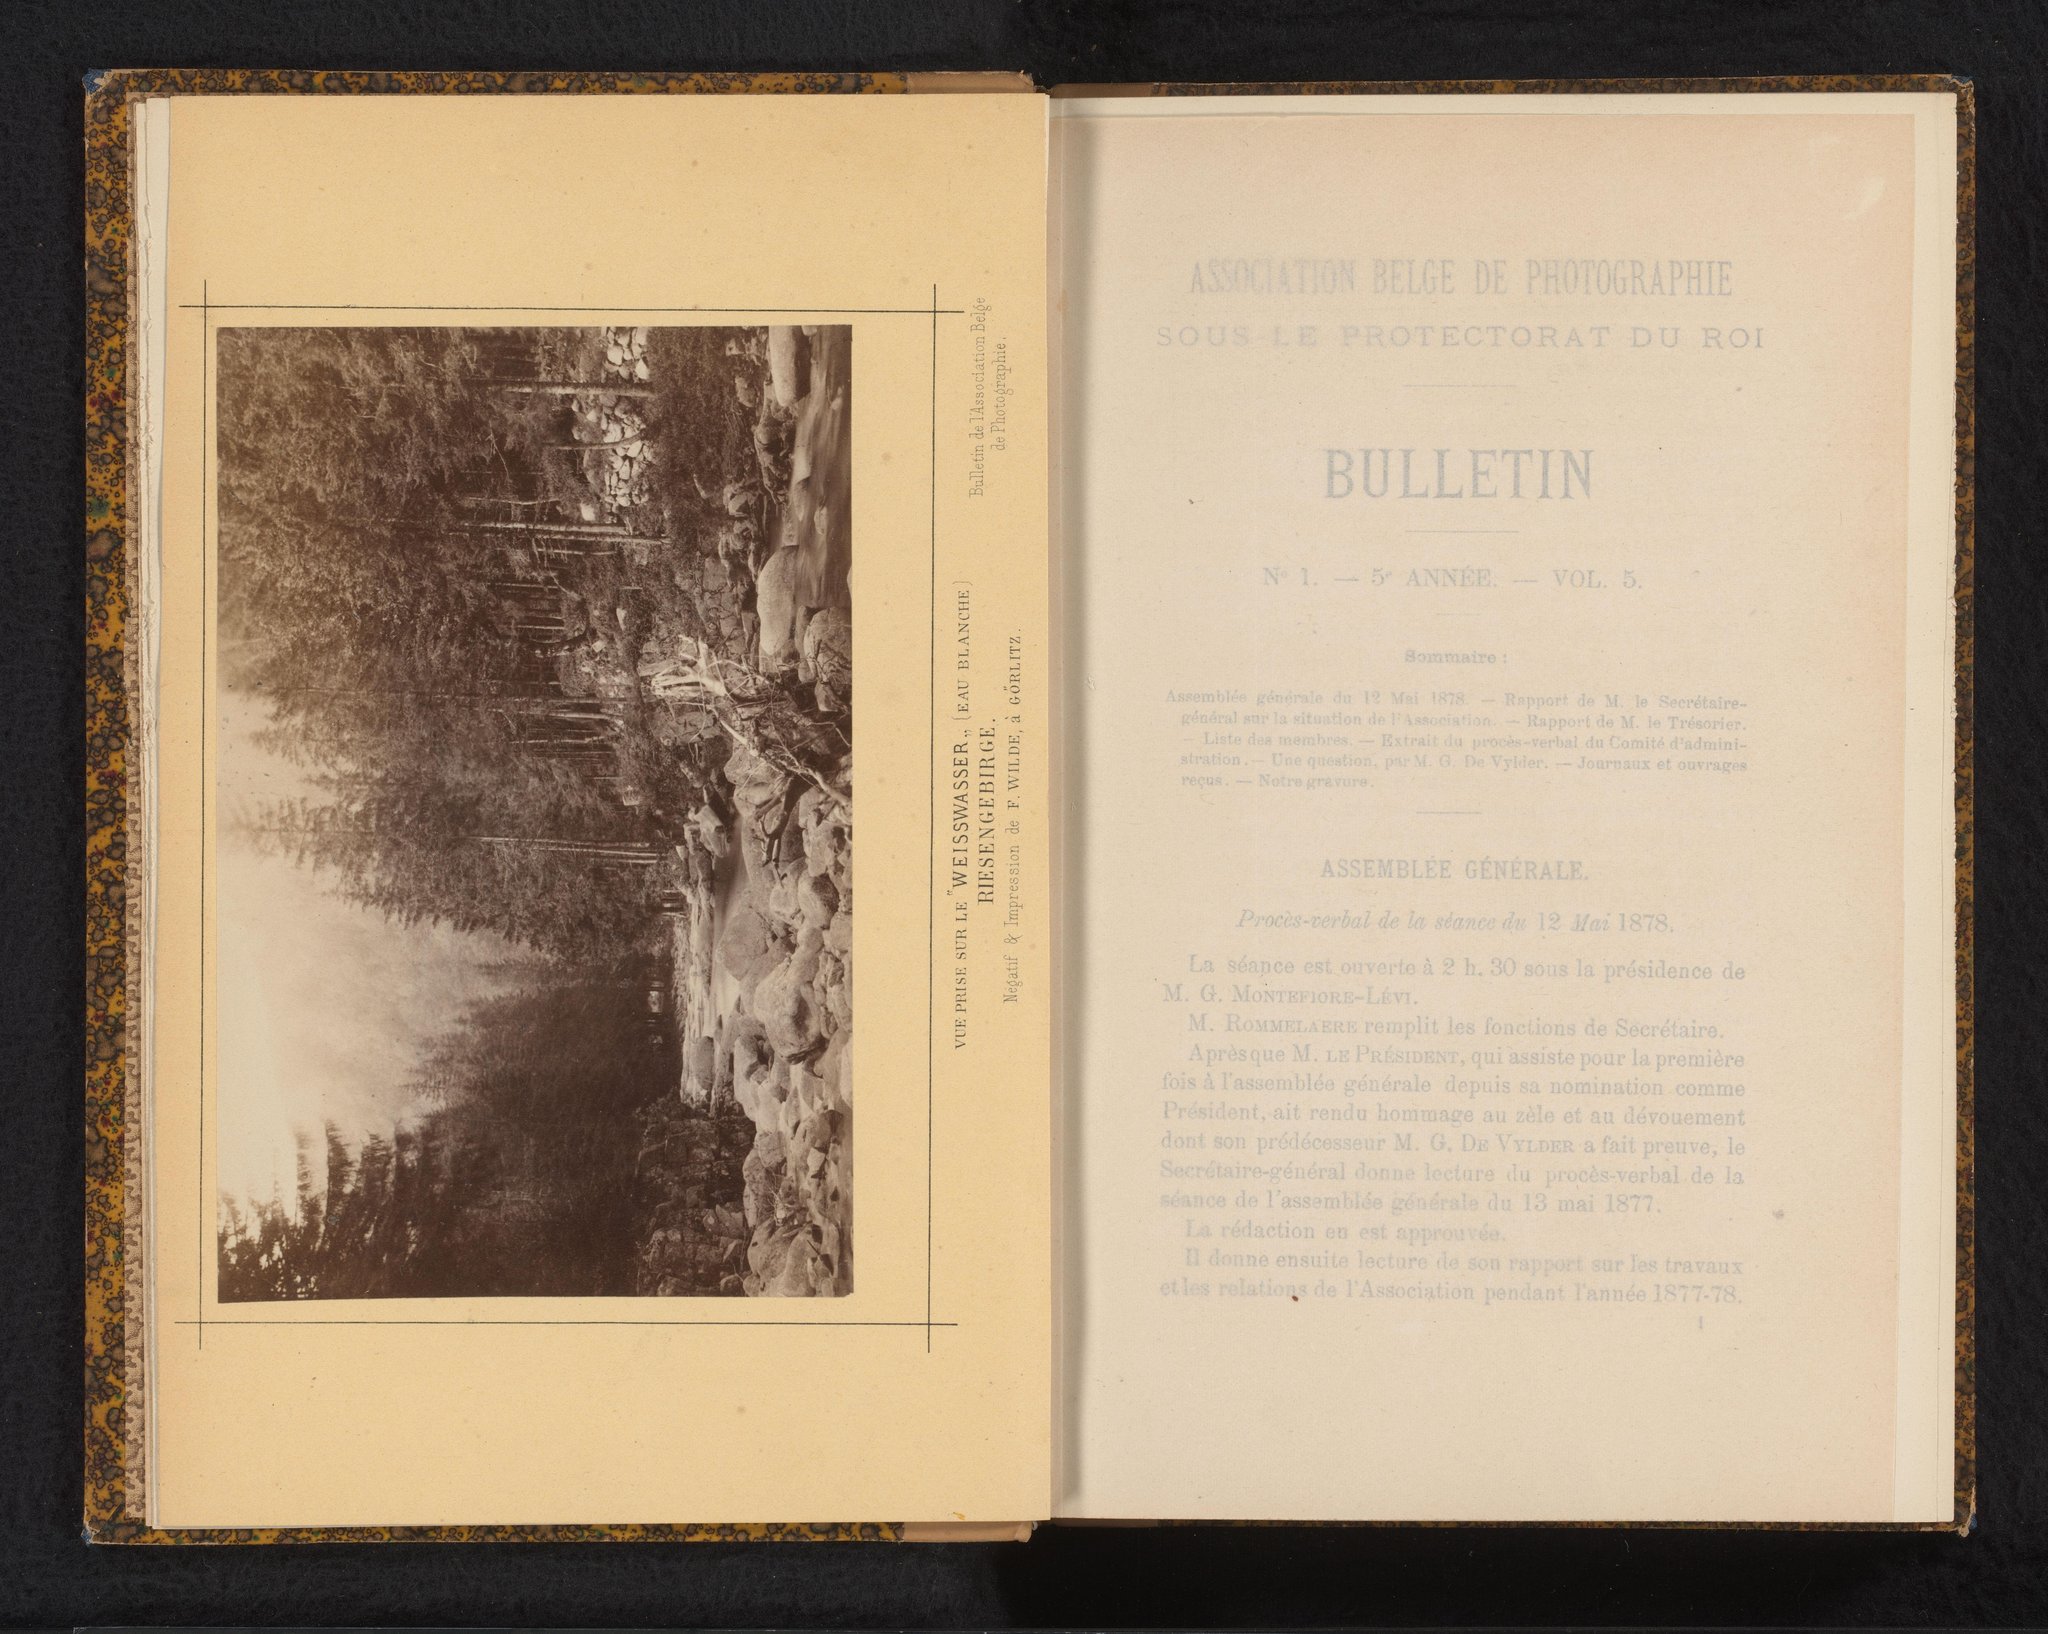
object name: page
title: Interieur met schrijftafel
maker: joseph albert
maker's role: printer, publisher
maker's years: 1825-1886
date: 1874-1879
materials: paper, cardboard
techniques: photograph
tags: writing-table, writing-desk, study; 'studiolo'; library